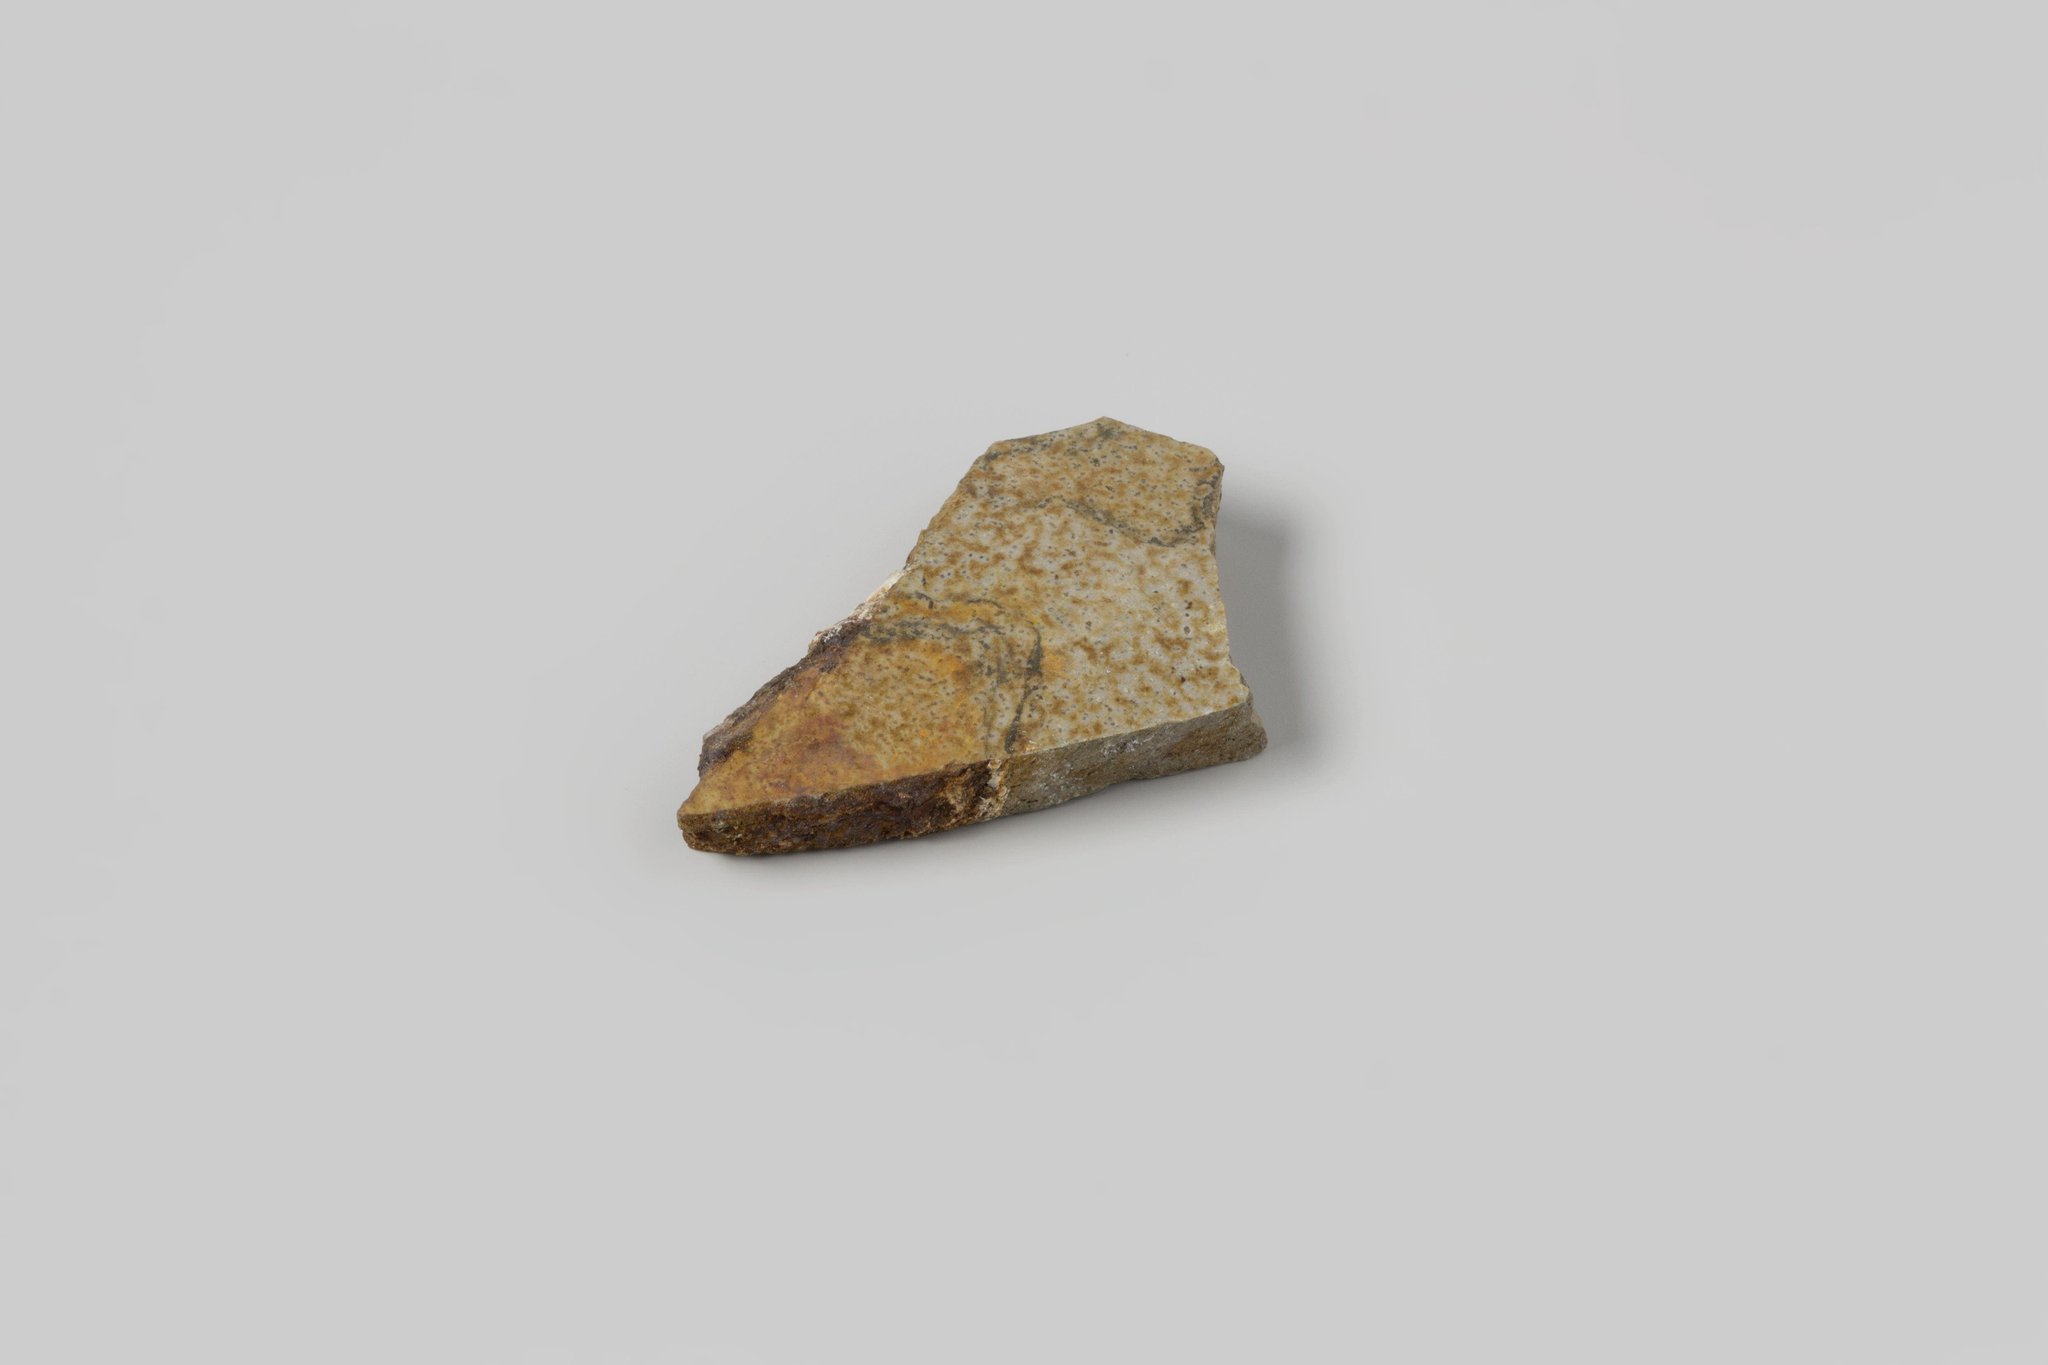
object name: ewer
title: Scherf van een kan uit het wrak van de Oost-Indiëvaarder Hollandia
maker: Anonymous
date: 1700-1743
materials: stoneware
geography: cologne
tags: verenigde oostindische compagnie, hollandia (schip), annet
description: Stoneware, Rhenish, Frechen-ware, jug; fragm of body.